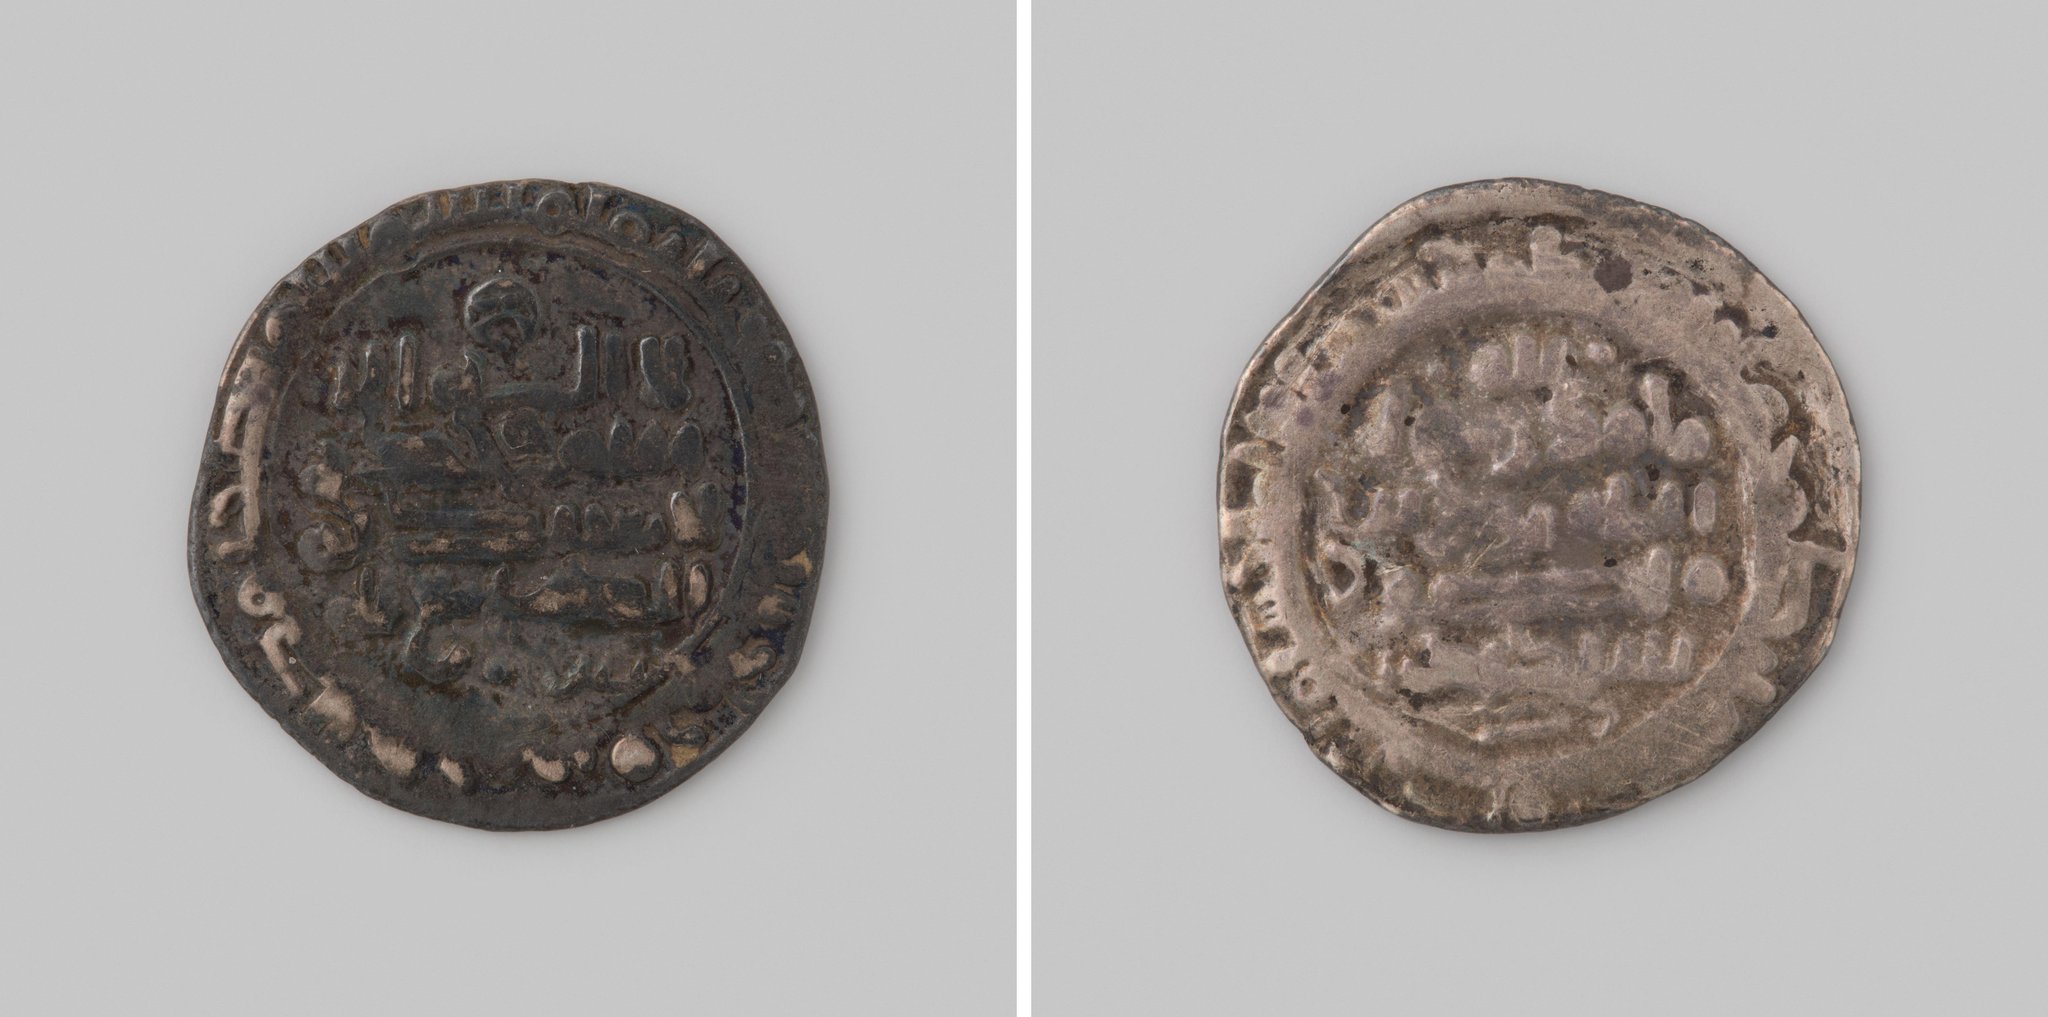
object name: coin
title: Dirhem van de Ghaznaviden, 365-387 [=976-997] uit Ferwan [?]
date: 976-997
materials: silver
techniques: striking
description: Zilveren munt. Voorzijde: binnen cirkel versiering, waaronder in Arabische lettertekens in Koefisch schrift in vier regels opschrift, de Kalima [=geloofsbelijdenis] ? Rondom cirkel omschrift in Arabische lettertekens in Koefisch schrift. Keerzijde: in Arabische lettertekens in Koefisch schrift opschrift in vier regels.